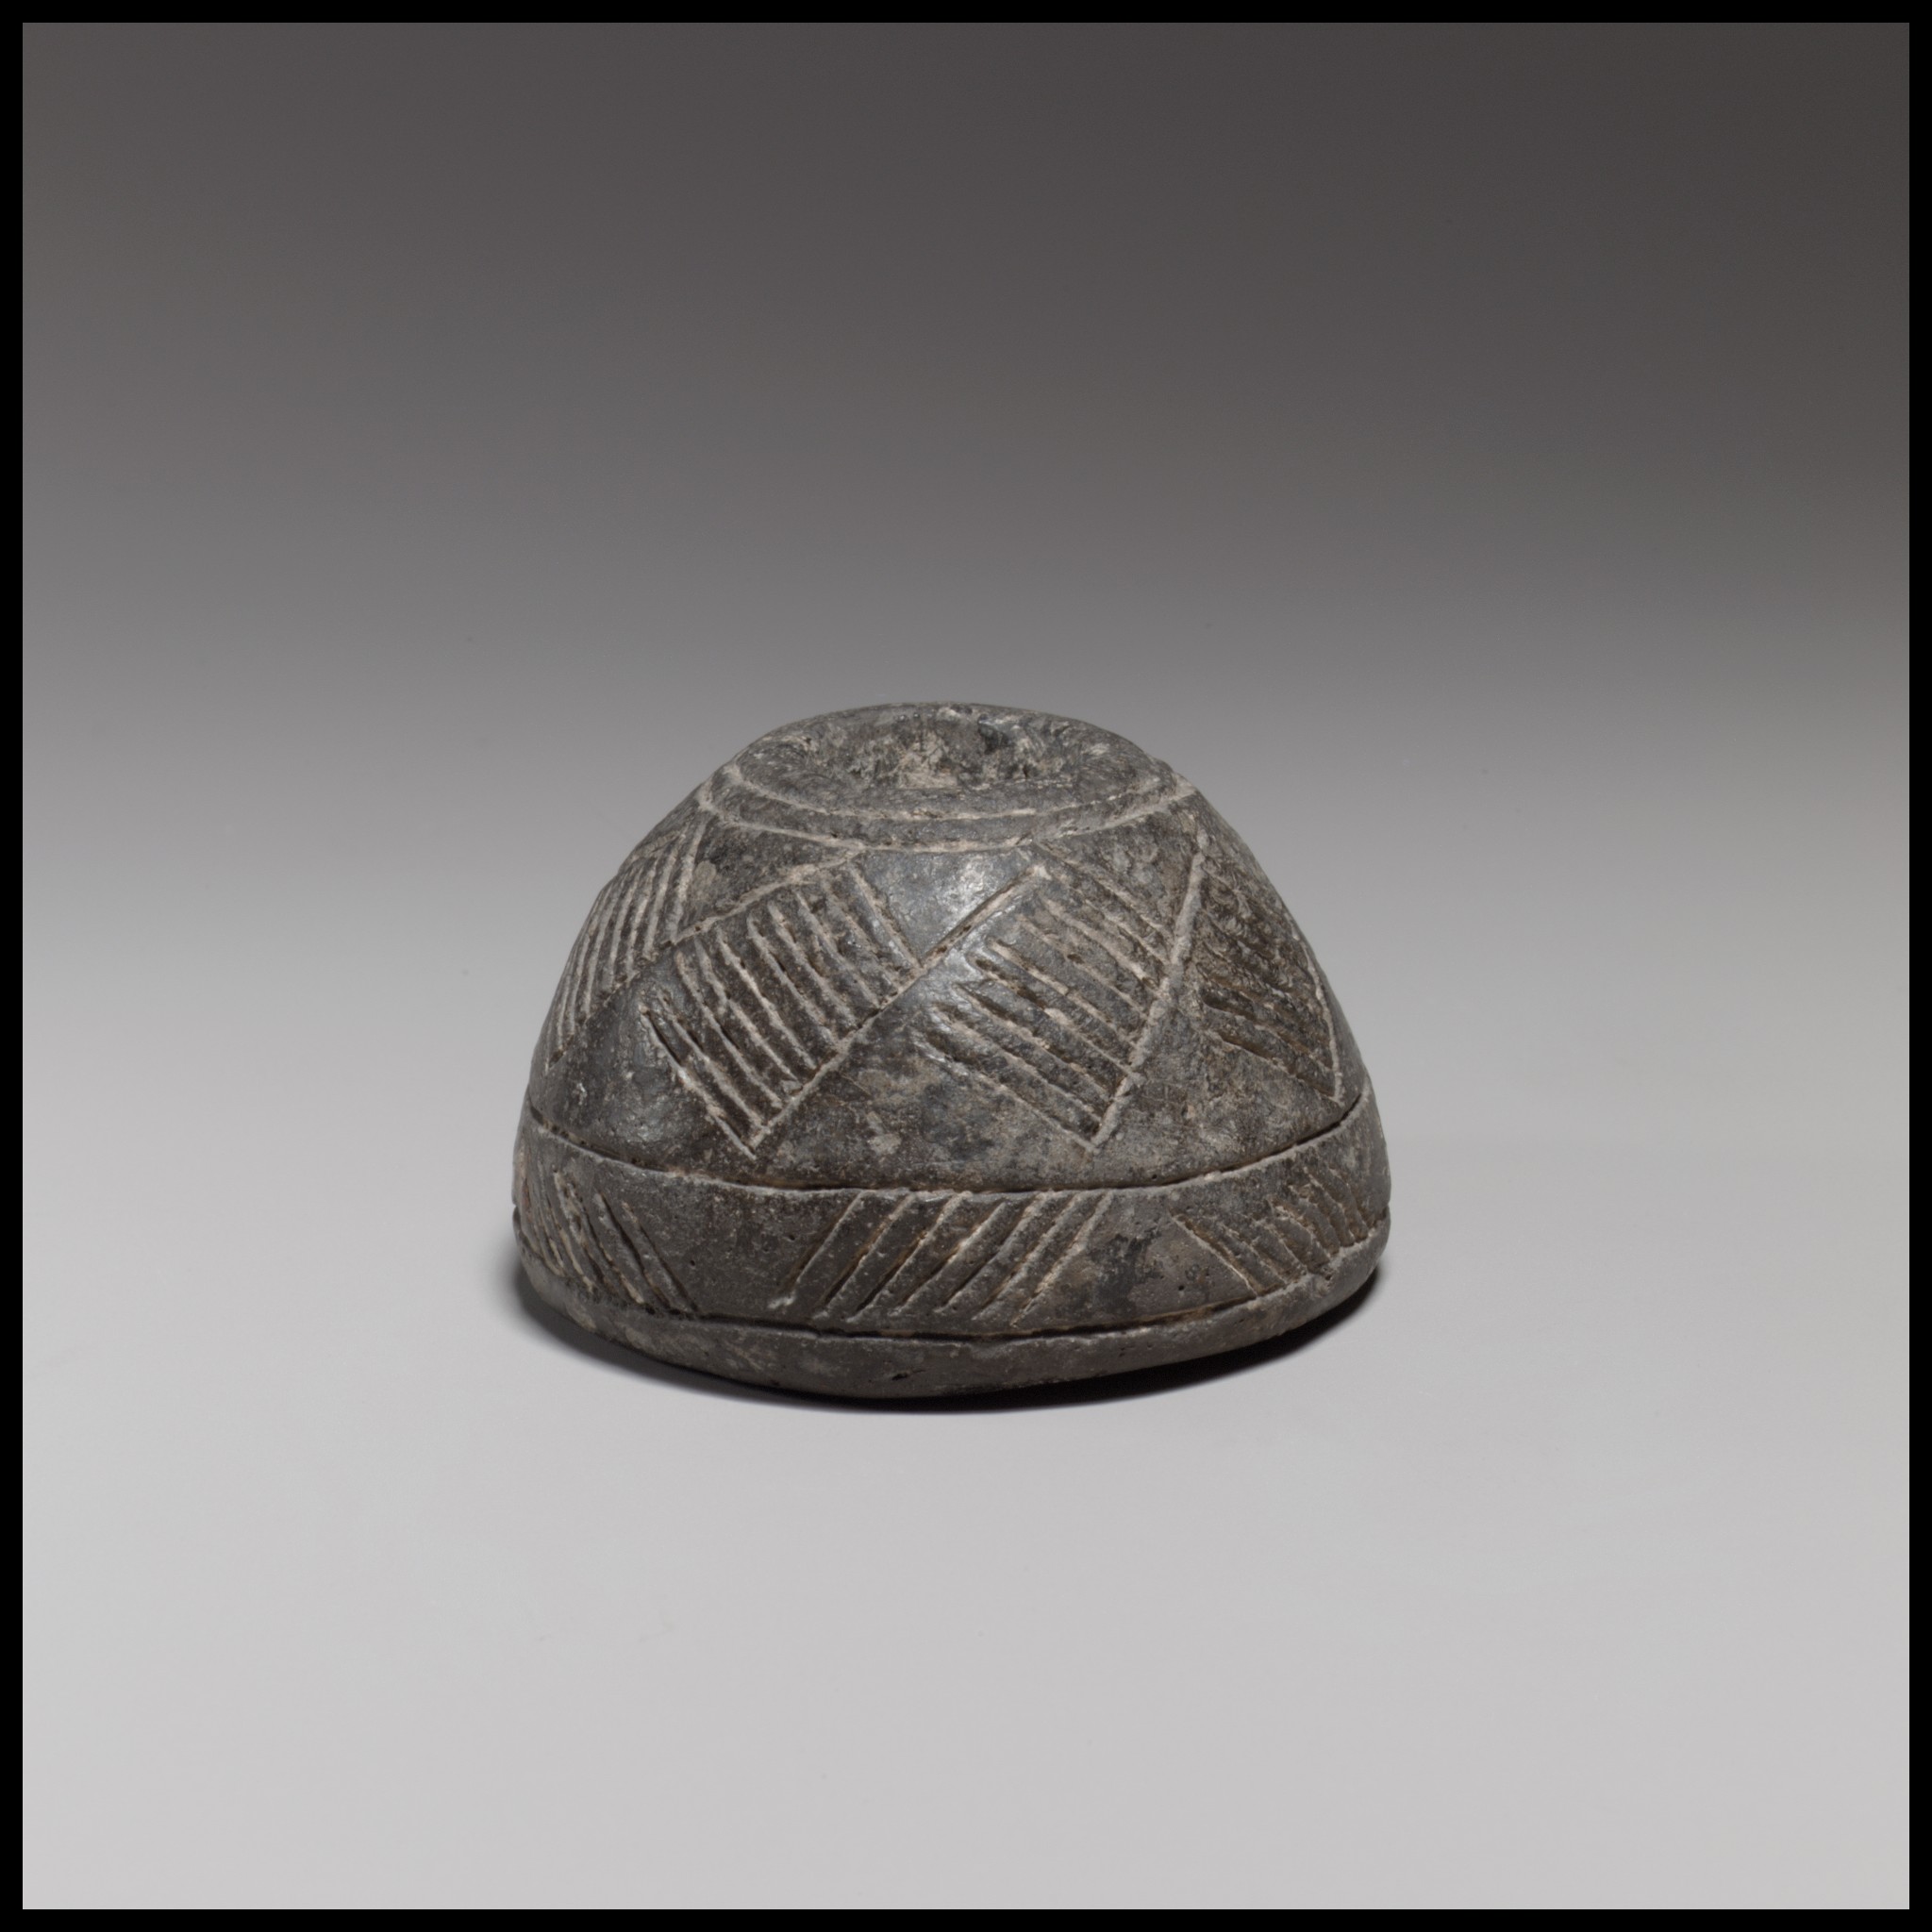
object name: spindle whorl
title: Terracotta spindle whorl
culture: cypriot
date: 1900-1725 BCE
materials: terracotta